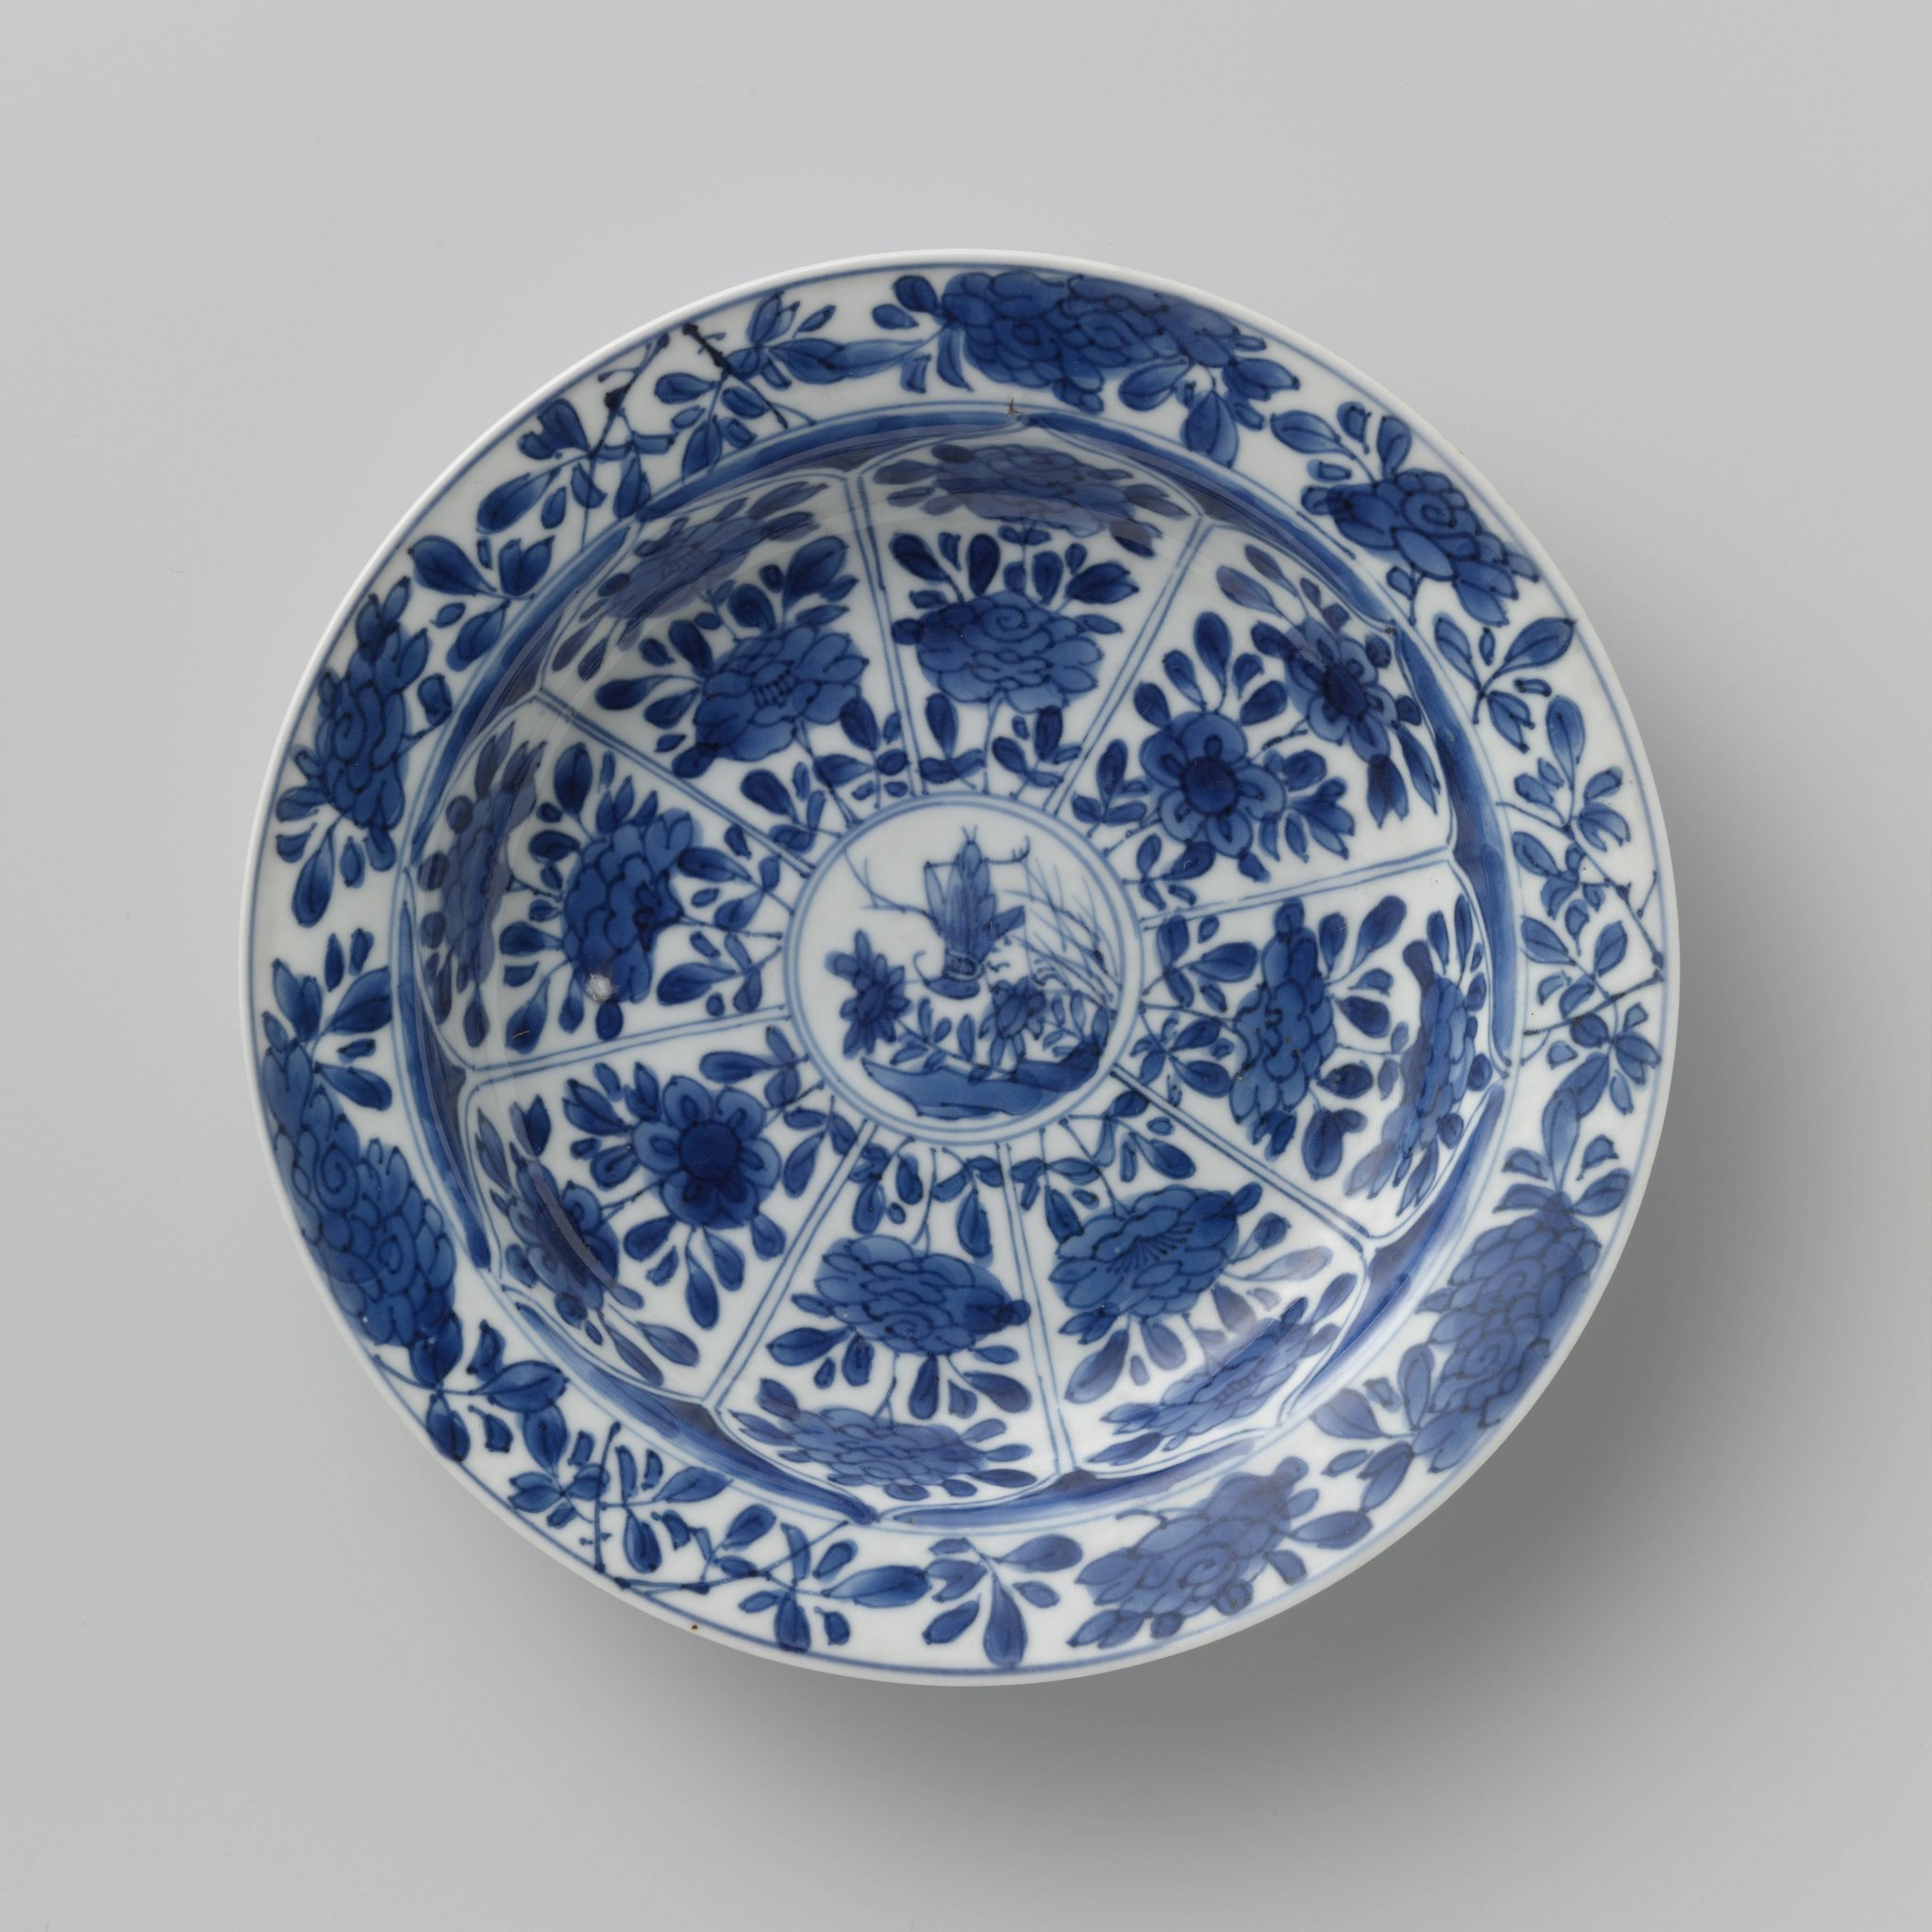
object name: platter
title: Saucer with panels in the shape of a flowerhead filled with flower sprays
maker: Anonymous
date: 1680-1720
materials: cobalt, glaze, paint, porcelain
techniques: firing, turning, vitrification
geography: china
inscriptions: mark